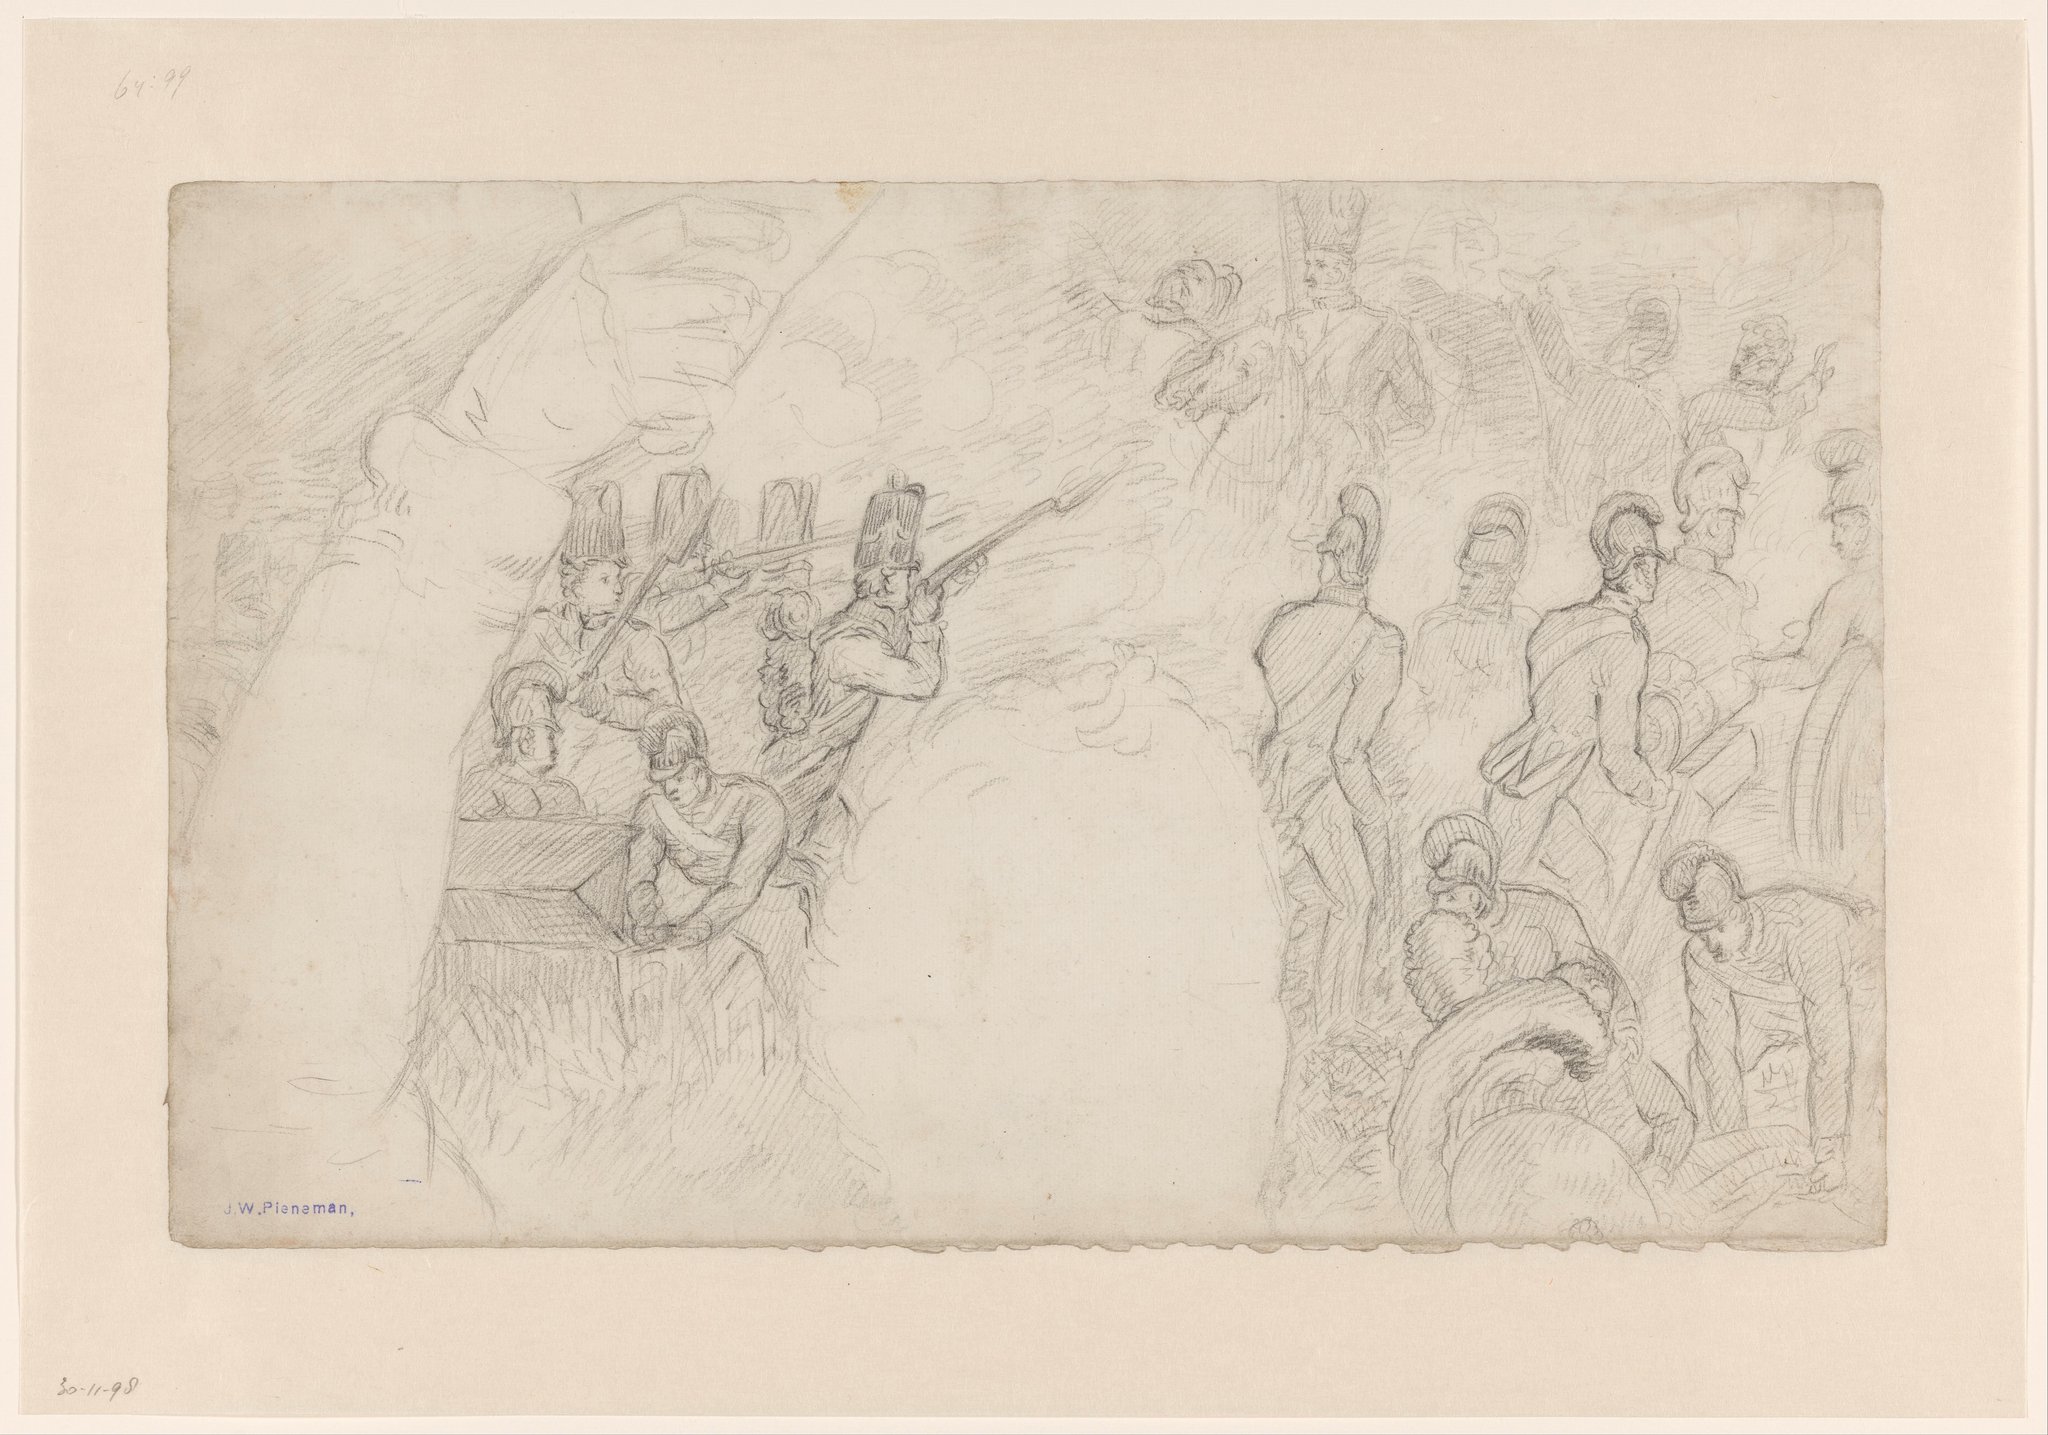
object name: drawing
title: Study for The Battle of Waterloo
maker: jan willem pieneman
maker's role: draughtsman, painter, print maker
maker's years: 1779-1853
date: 1824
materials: chalk, paper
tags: battle (+ land forces), historical events and situations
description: Around the empty spaces for the arm and head of Fremantle, Wellington’s aide-de-camp, Pieneman drew a group of infantrymen firing their muskets at the enemy. Extra ammunition was carried onto the battlefield in chests. Such details are more visible in Pieneman’s drawings than in his painting. However, oil proved a better medium for representing musket shots and the associated smoke.